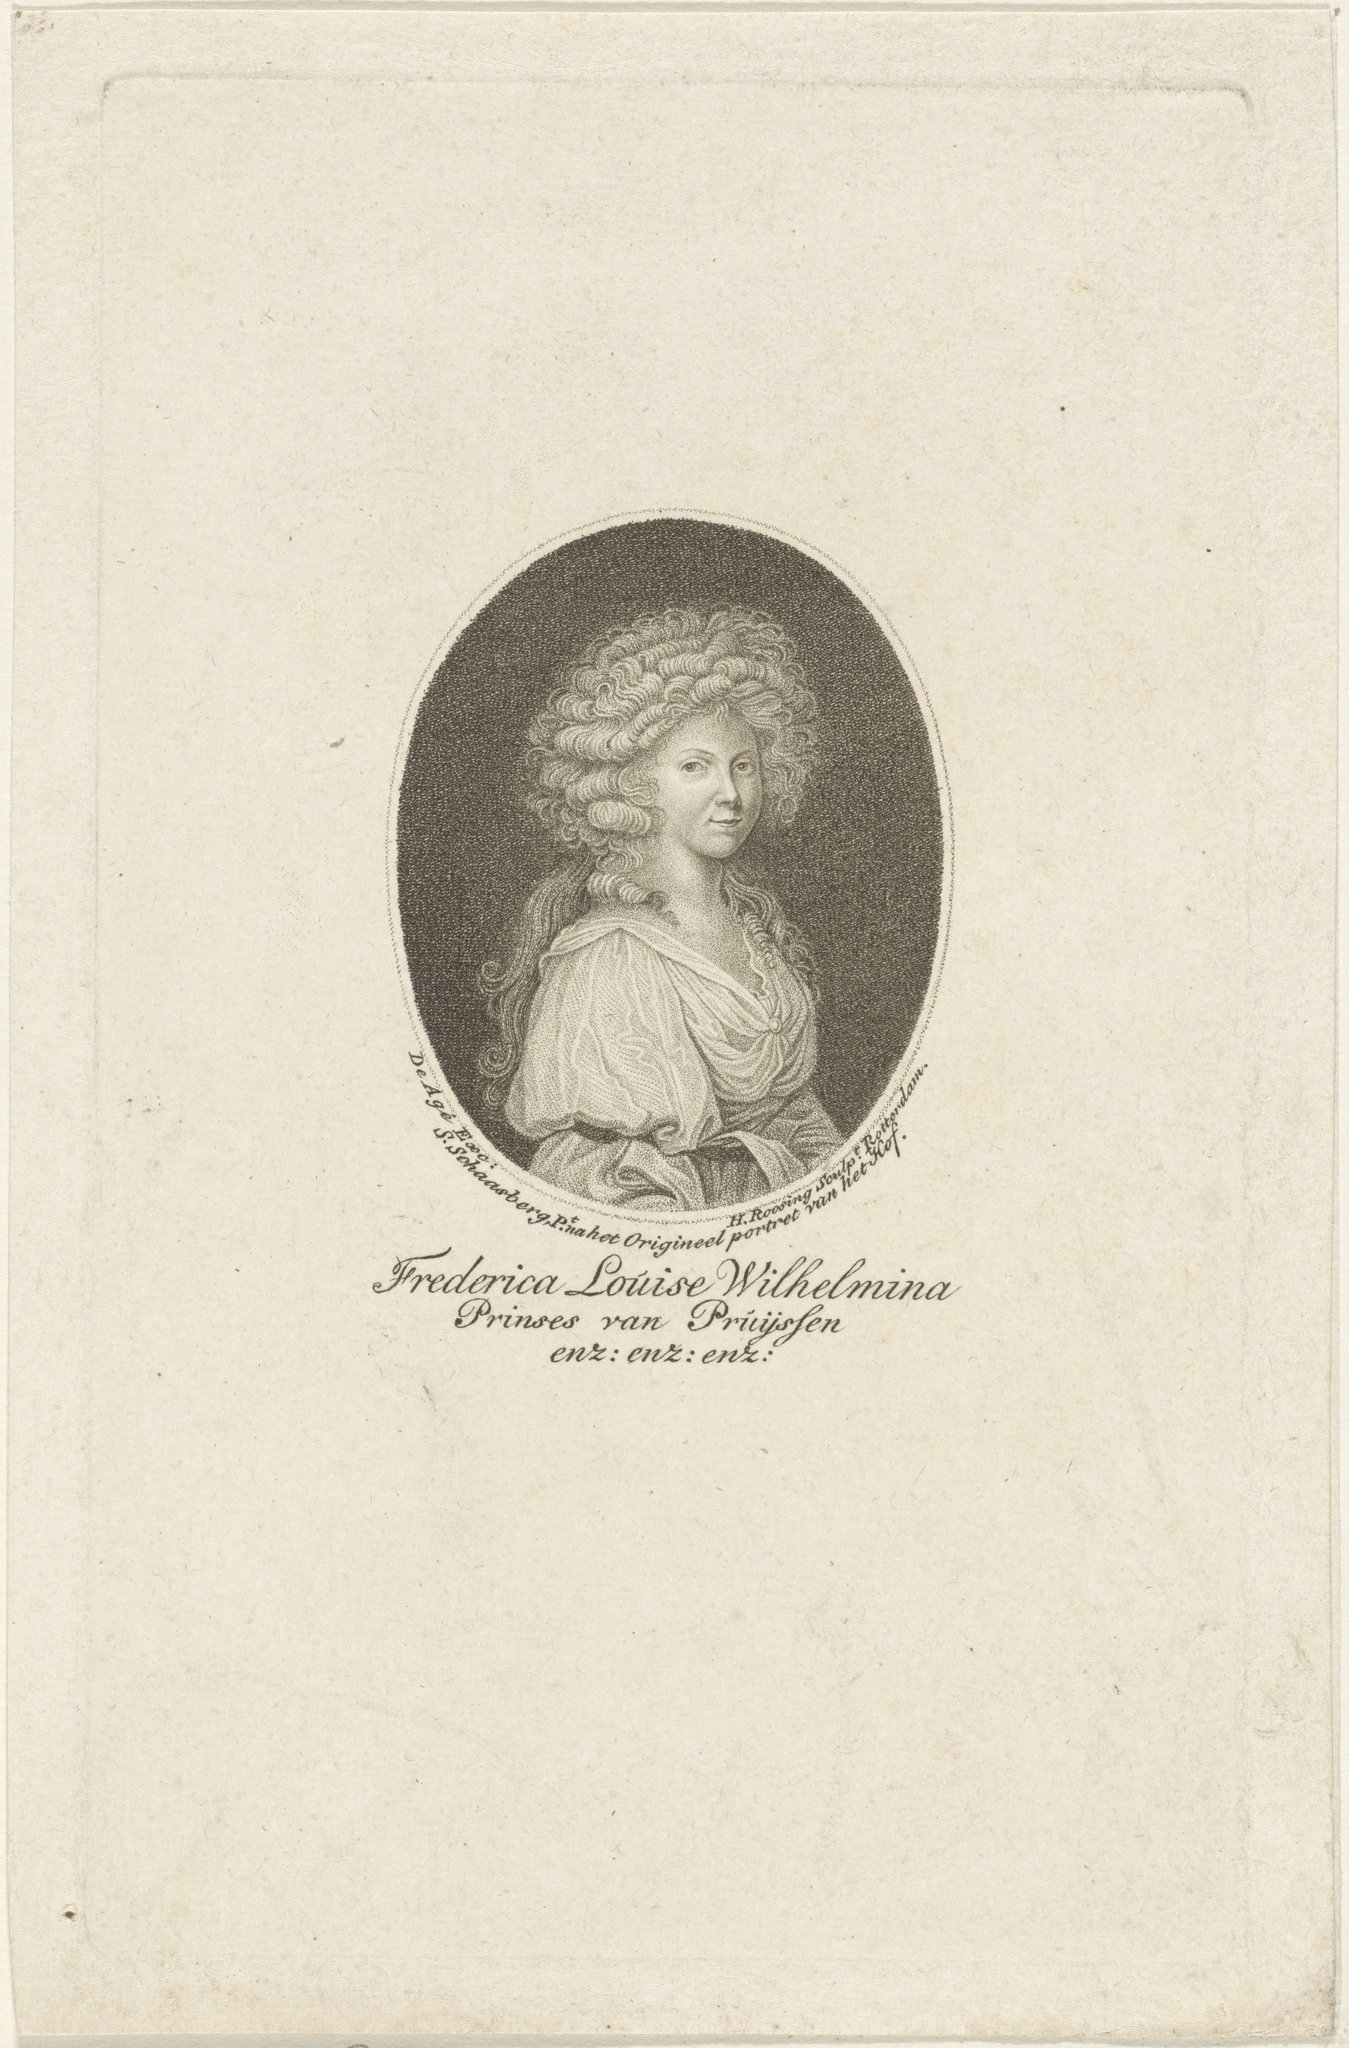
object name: print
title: Portret van Wilhelmina van Pruisen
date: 1790-1801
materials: paper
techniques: engraving, etching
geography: the hague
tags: berlin, the hague, wilhelmina frederica louisa (koningin der nederlanden)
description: Portret van Wilhelmina in een ovaal. In de ondermarge haar naam en titels.